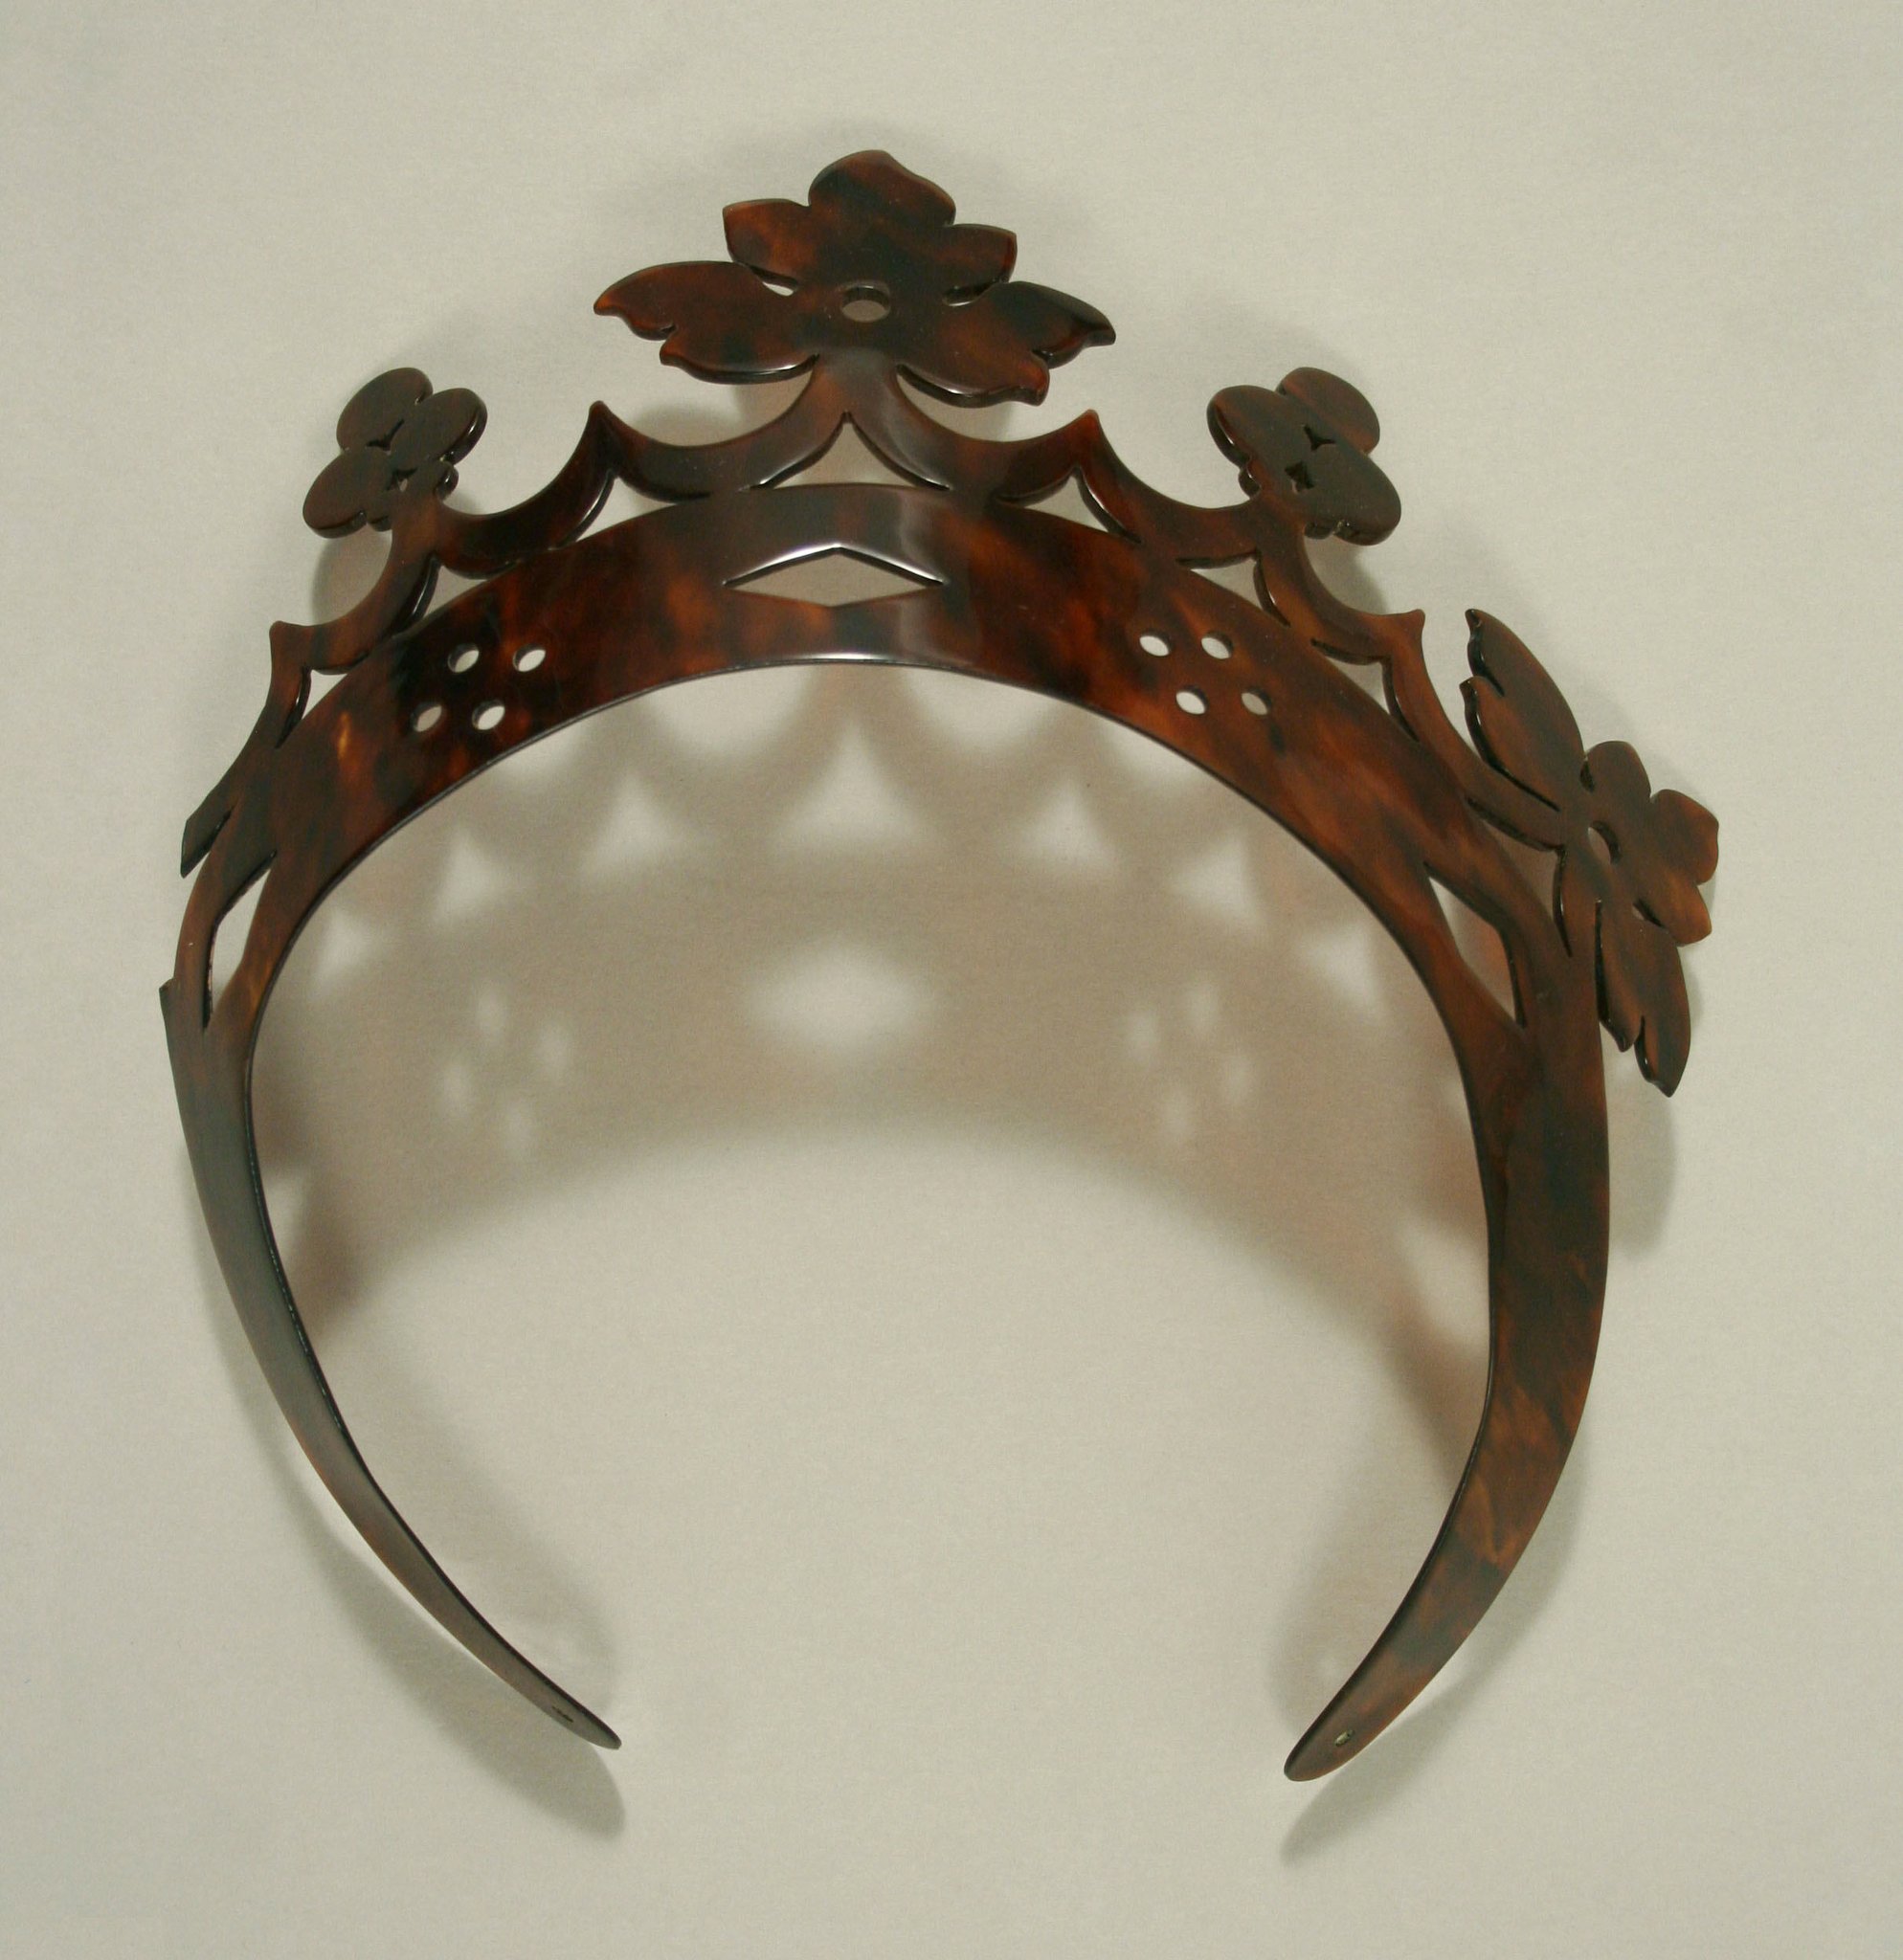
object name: tiara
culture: american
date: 1870-1889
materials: plastic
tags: diadems